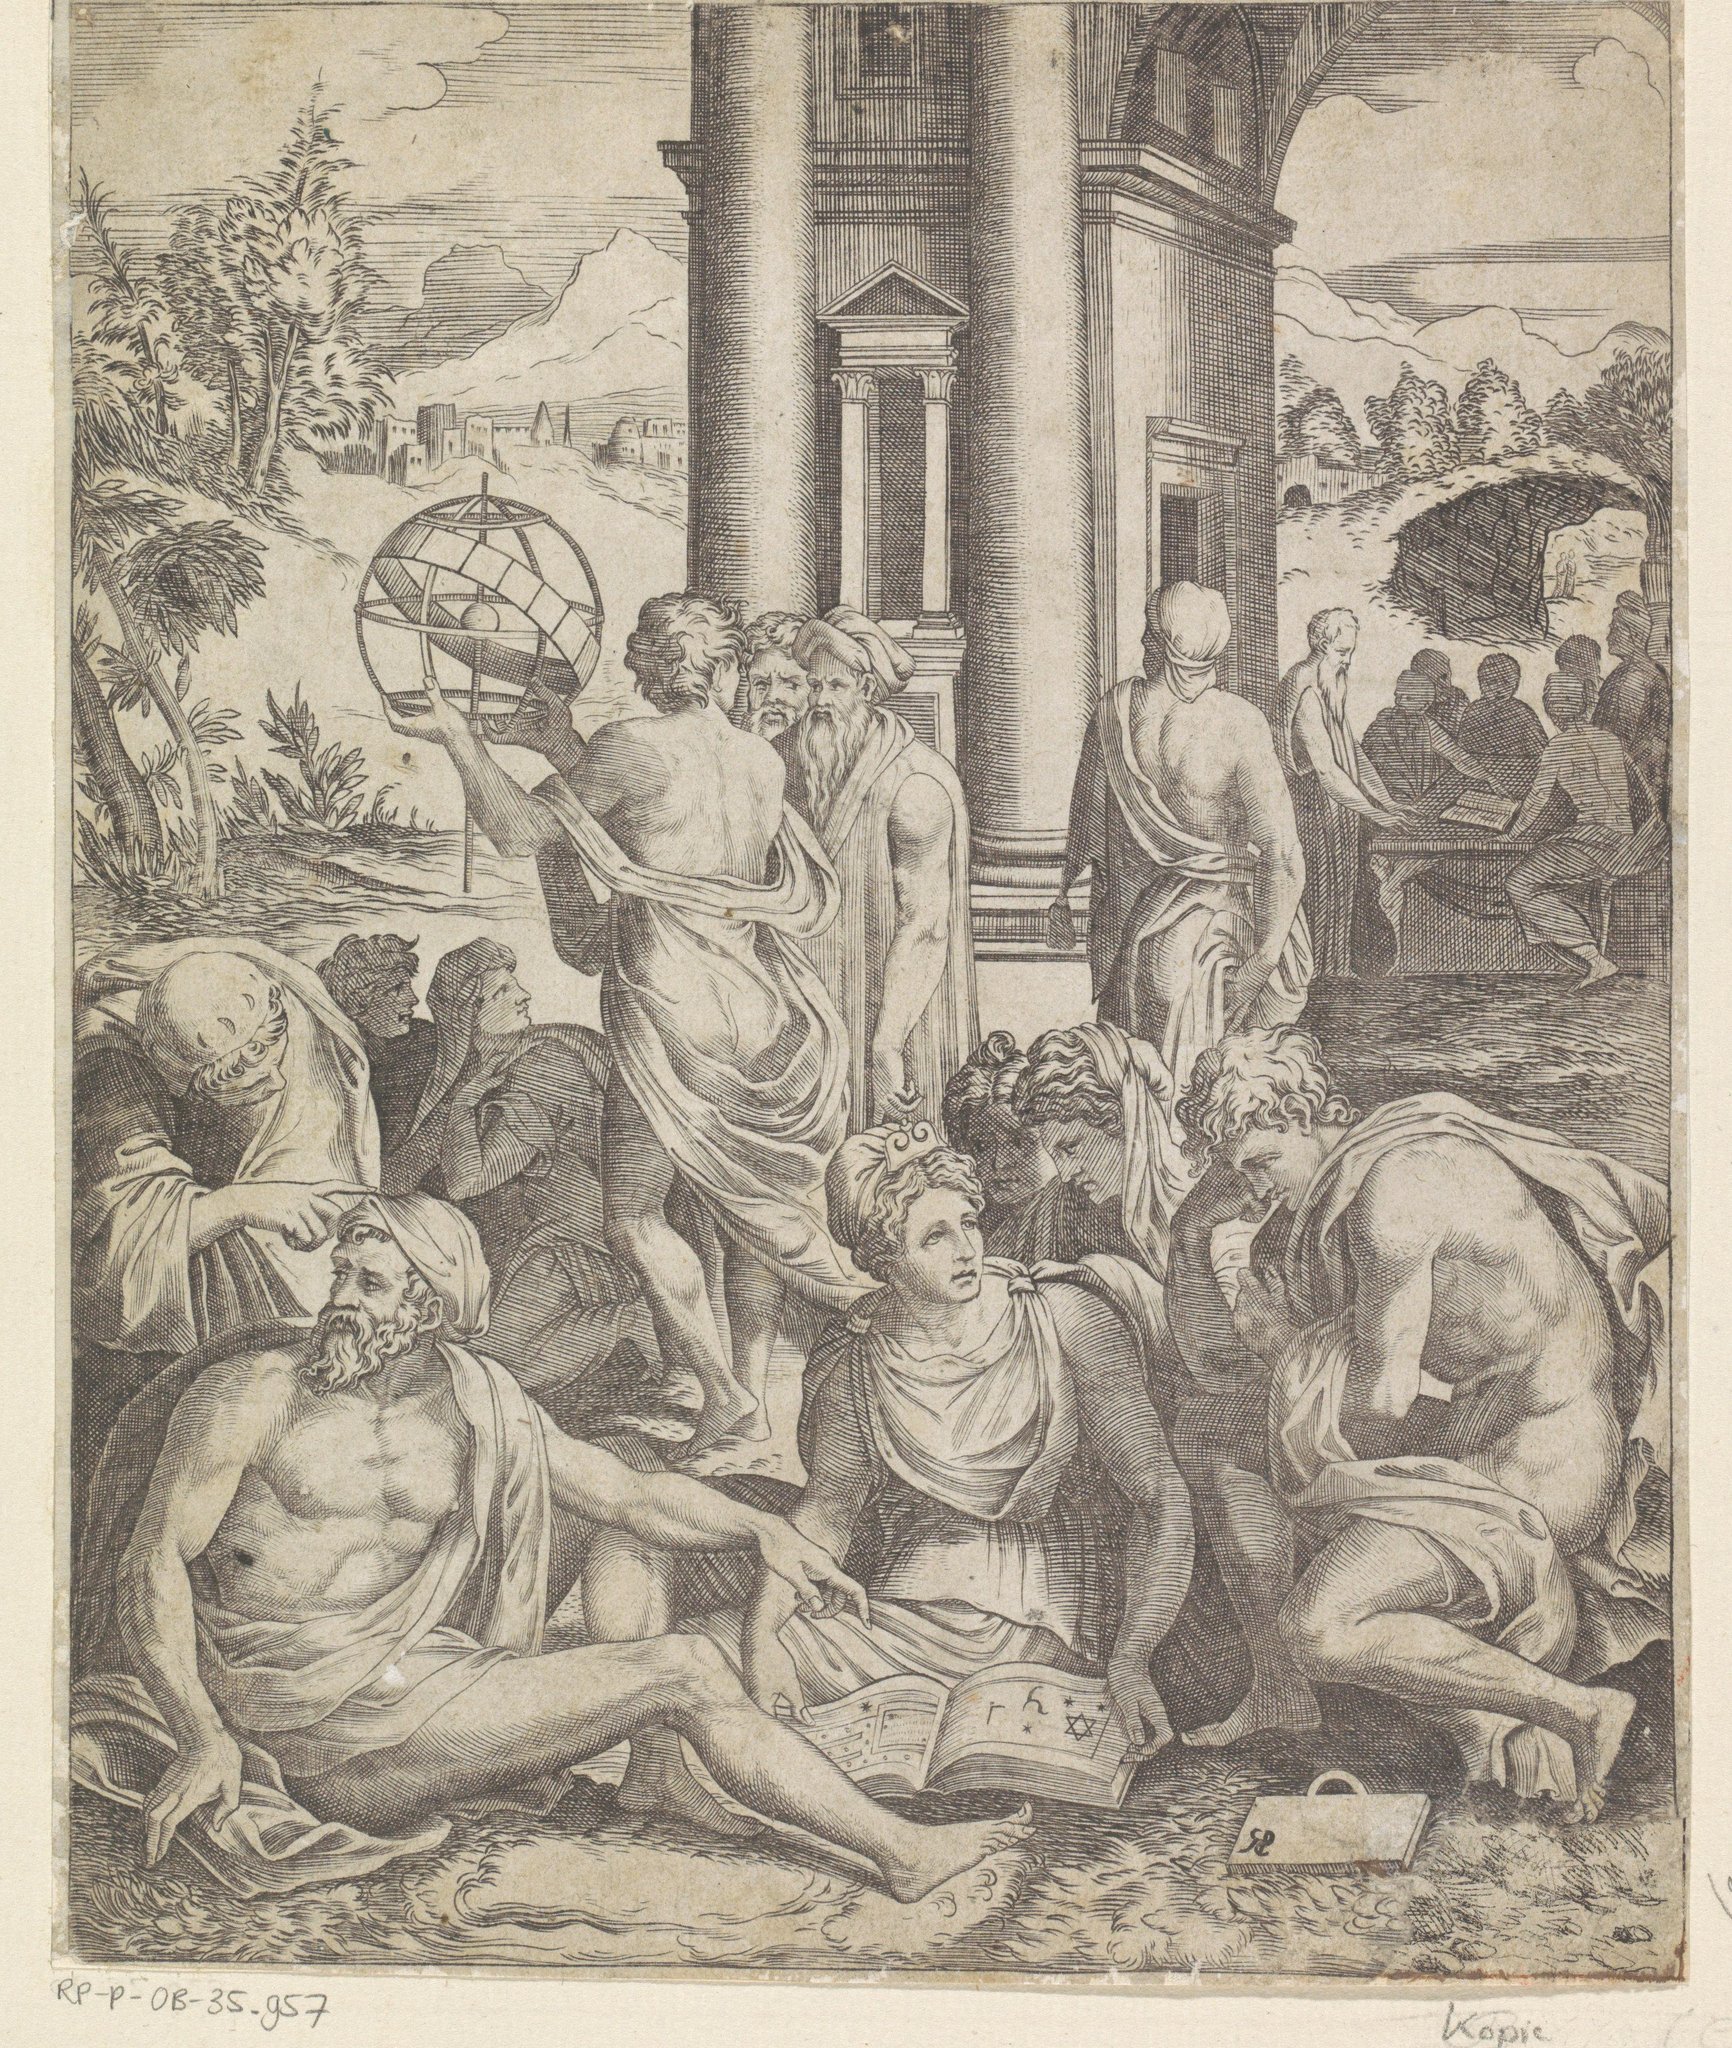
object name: print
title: Groep geleerden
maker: marco dente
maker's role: print maker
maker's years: 1486-1527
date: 1498-1532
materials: paper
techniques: printmaking, engraving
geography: italy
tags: group of scholars or philosophers, armillary sphere, skeleton celestial globe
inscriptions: collector's mark: Lugt 240, collector's mark: Lugt 12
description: Een groep geleerden, waaronder drie vrouwen, in een landschap. Op de voorgrond een groep geleerden gebogen over een boek, dat wordt opengehouden door een van de vrouwen. Op de achtergrond links toont een jonge geleerde een armillarium aan twee oudere geleerden en twee studenten. Onder een boog een groep geleerden rond een tafel, gebogen over geschriften.